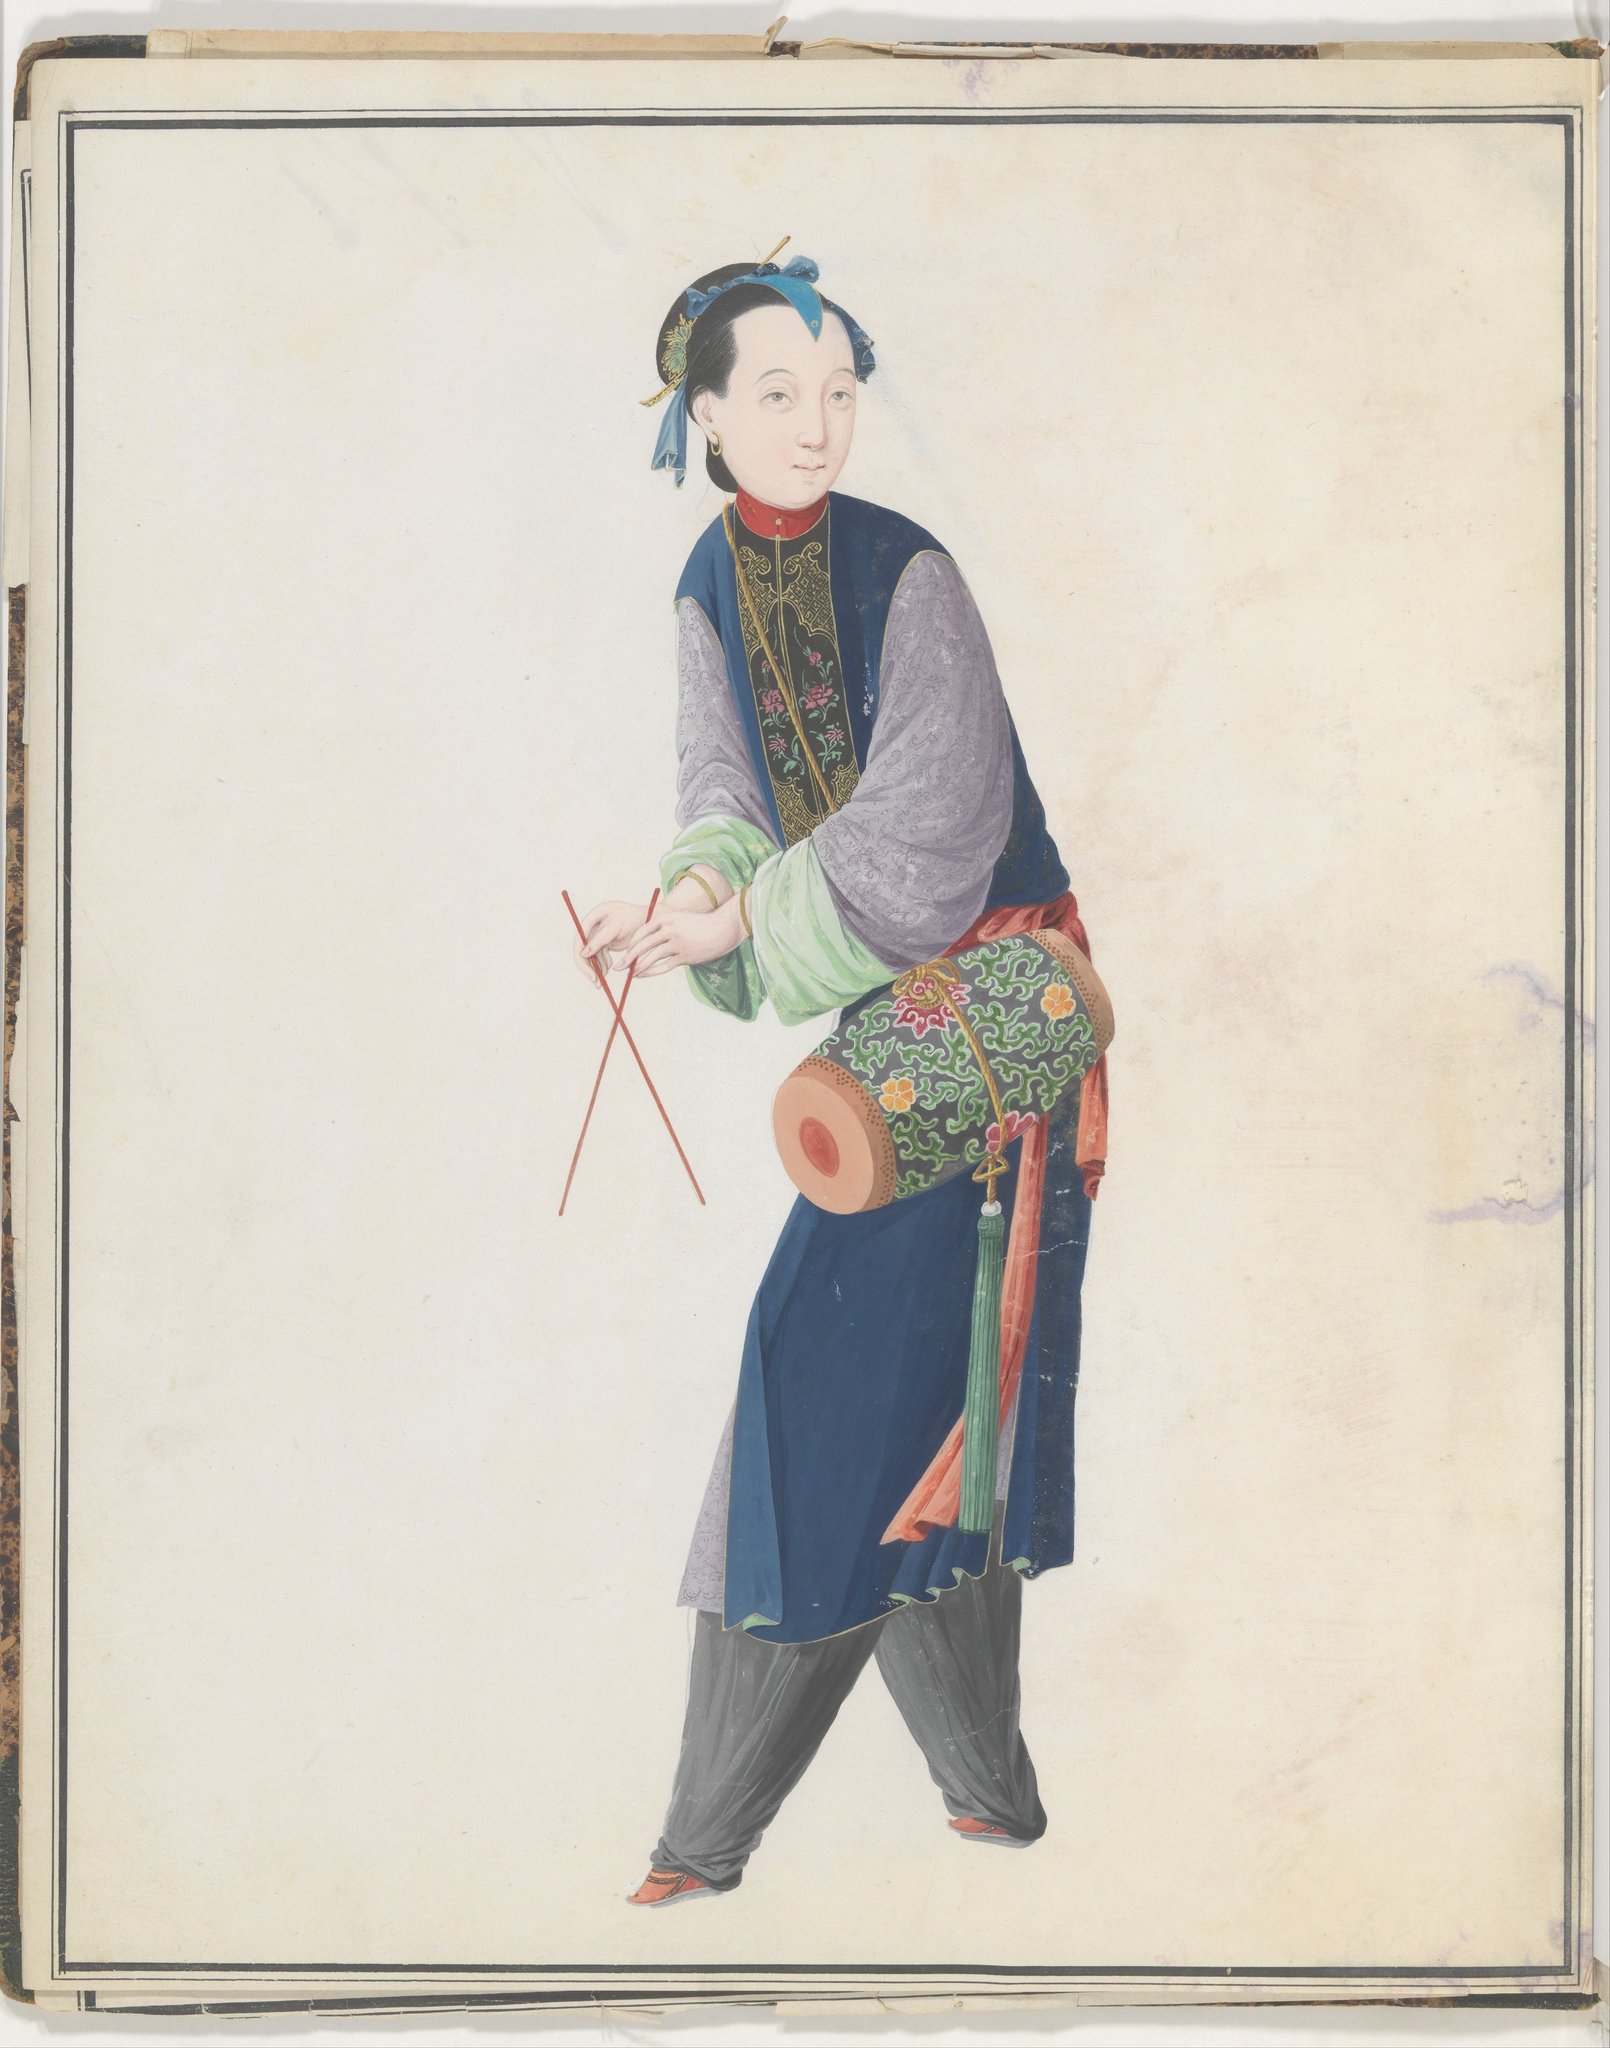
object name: watercolor of musician playing drum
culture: chinese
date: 1767-1800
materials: paper, watercolor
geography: china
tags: musical instruments,women,musicians